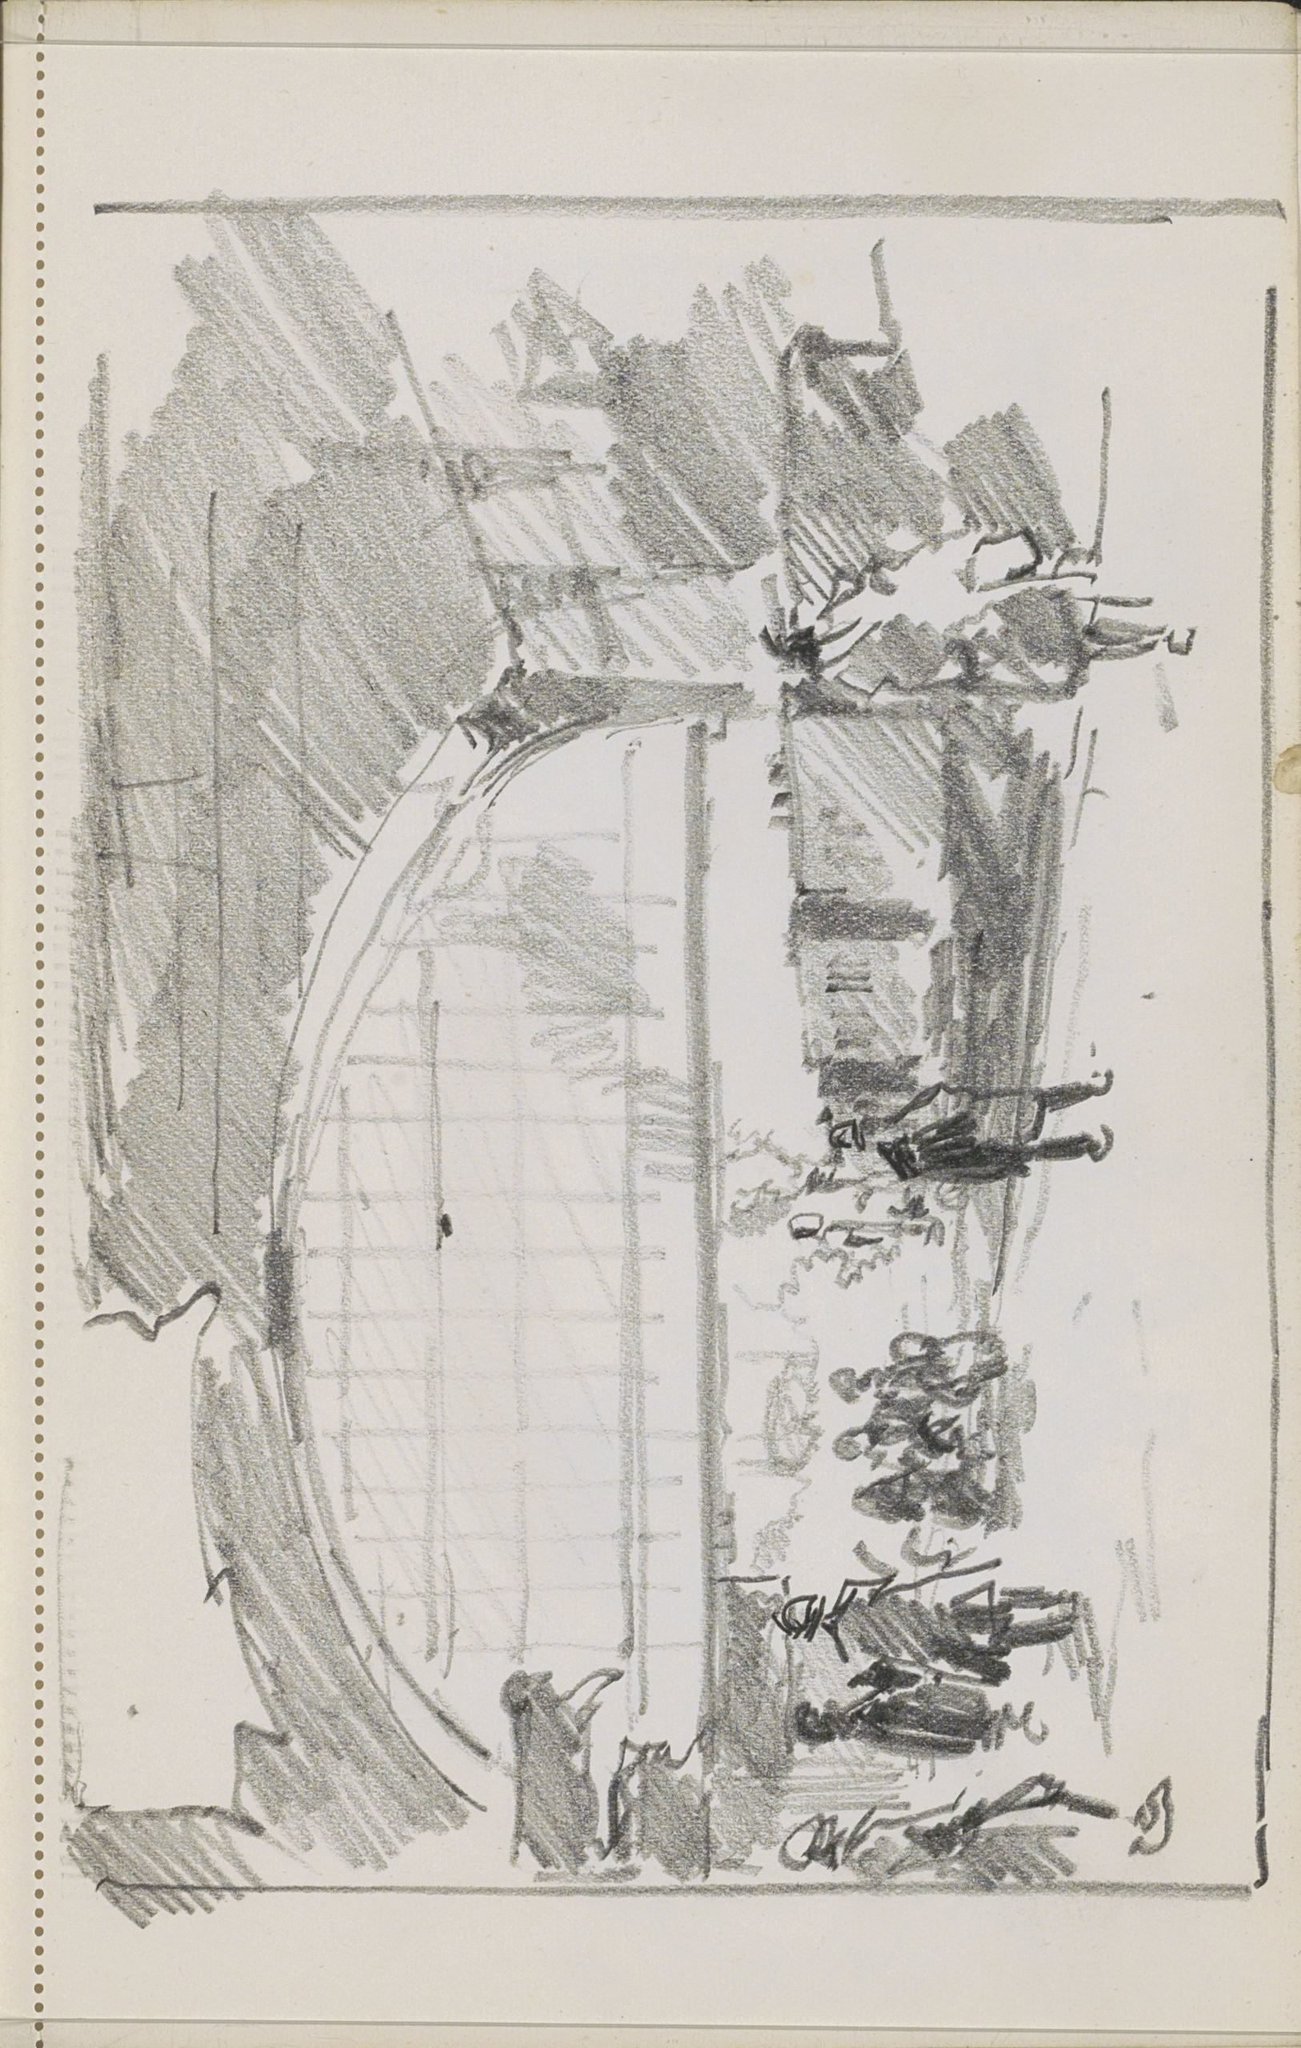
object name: sketchbook leaf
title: Figuren op een overkapt treinperron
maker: cornelis vreedenburgh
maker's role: draughtsman, print maker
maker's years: 1880-1946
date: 1890-1946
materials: paper, pencil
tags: platform (railway, tramway)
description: Blad 42 recto uit een schetsboek met 53 bladen.